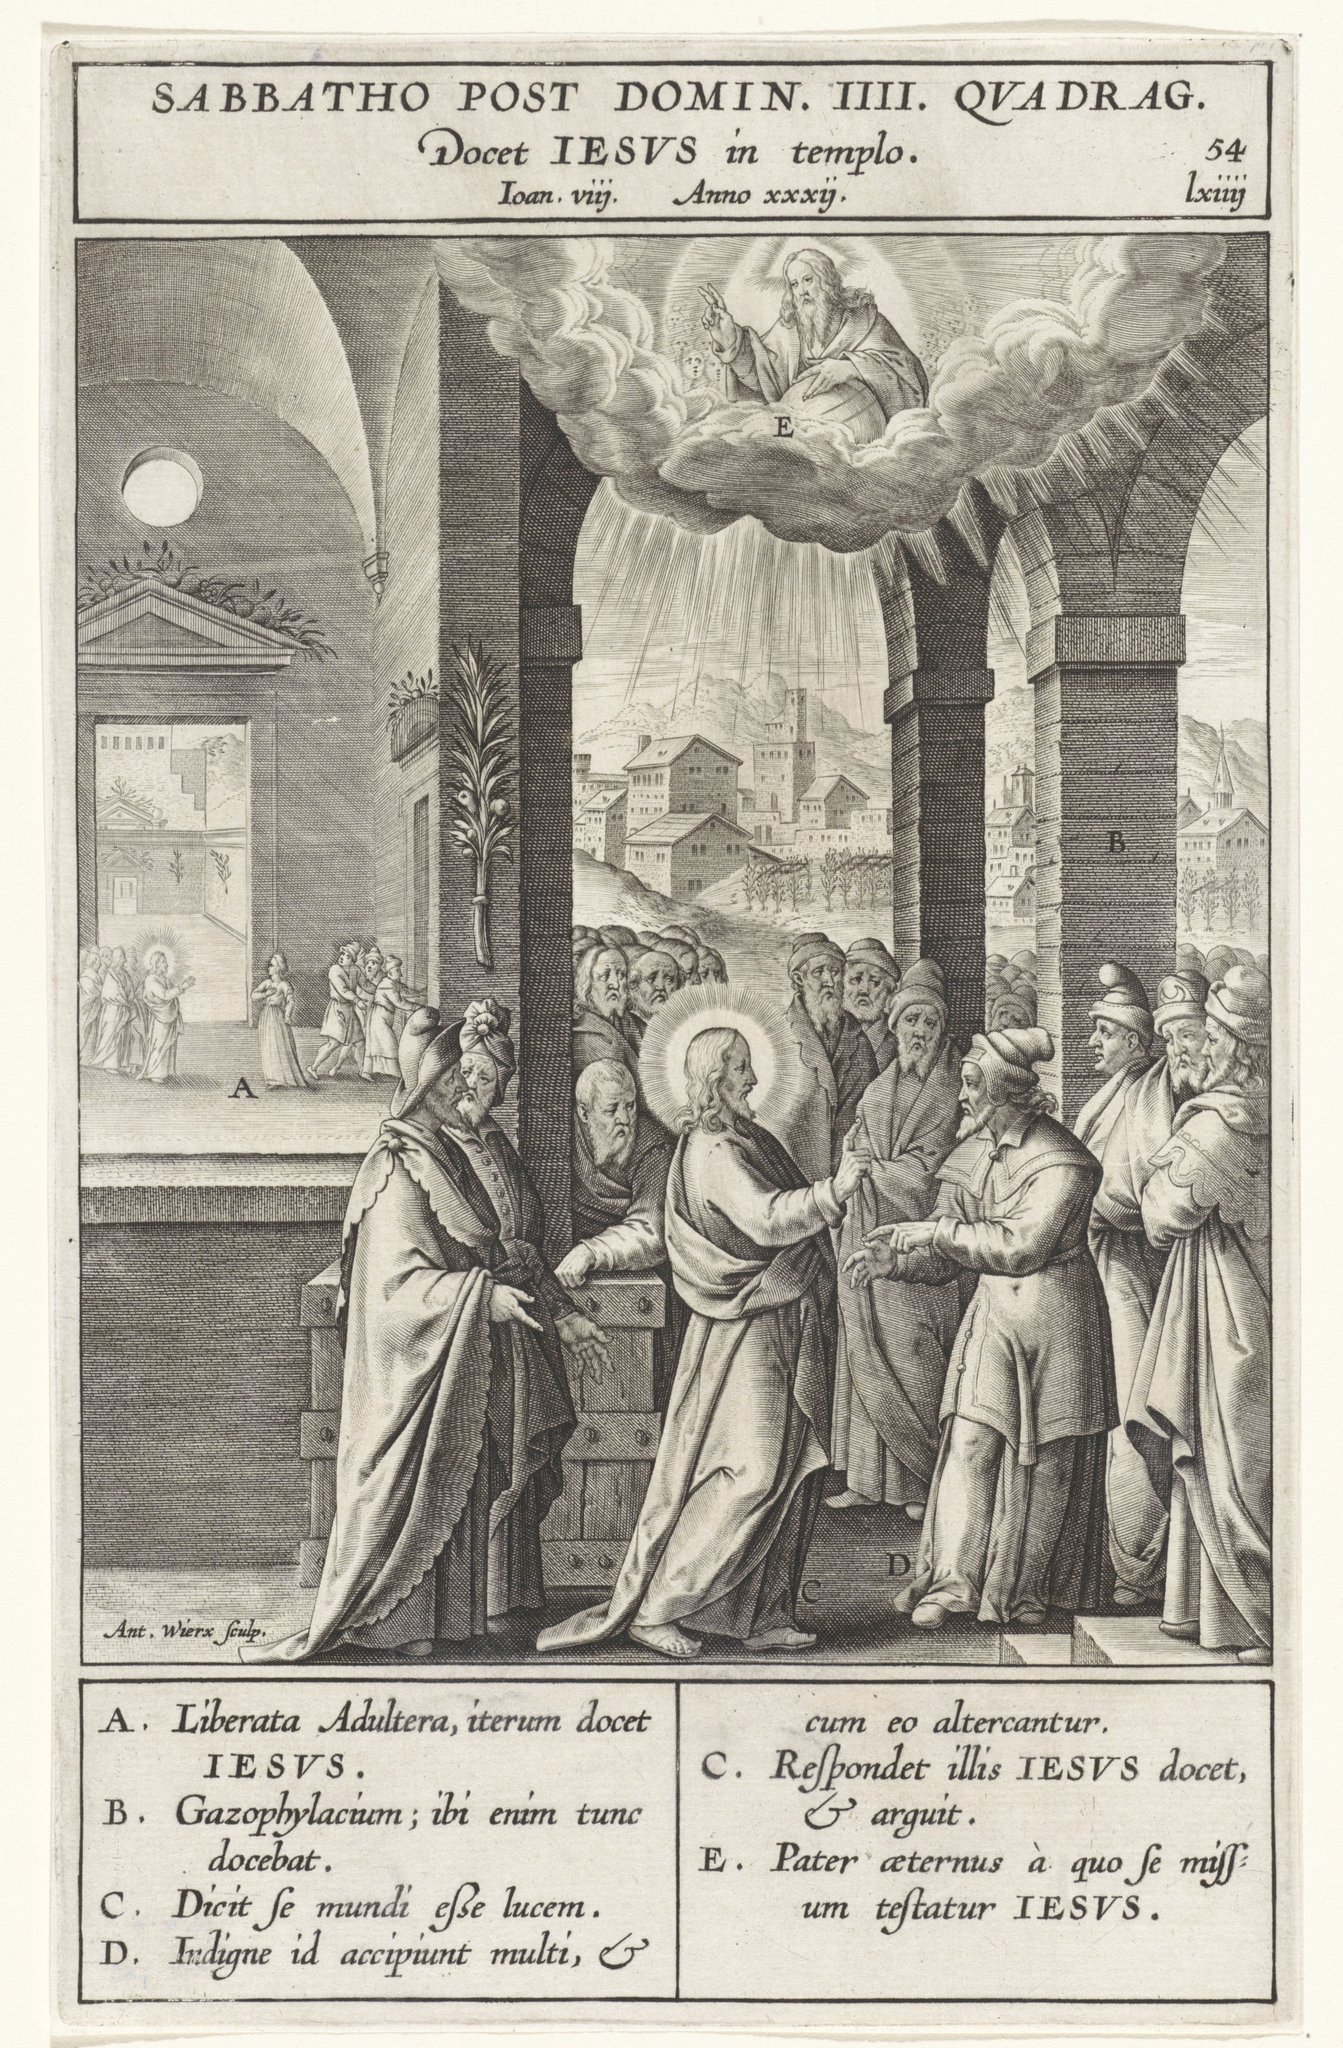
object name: print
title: Sabbatho Post Domin. IIII. Qvadrag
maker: antonie wierix (ii)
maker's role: draughtsman, print maker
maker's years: 1555-1604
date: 1593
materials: paper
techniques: engraving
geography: antwerp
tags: god the father, christ preaching in the temple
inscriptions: collector's mark: Lugt 2165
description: In de schatkamer van de tempel geeft Christus onderricht. Op de achtergrond is de overspelige vrouw te zien. In de hemel God de Vader. Bij verschillende elementen uit de voorstelling staan letters die corresponderen met de legenda in de marge.